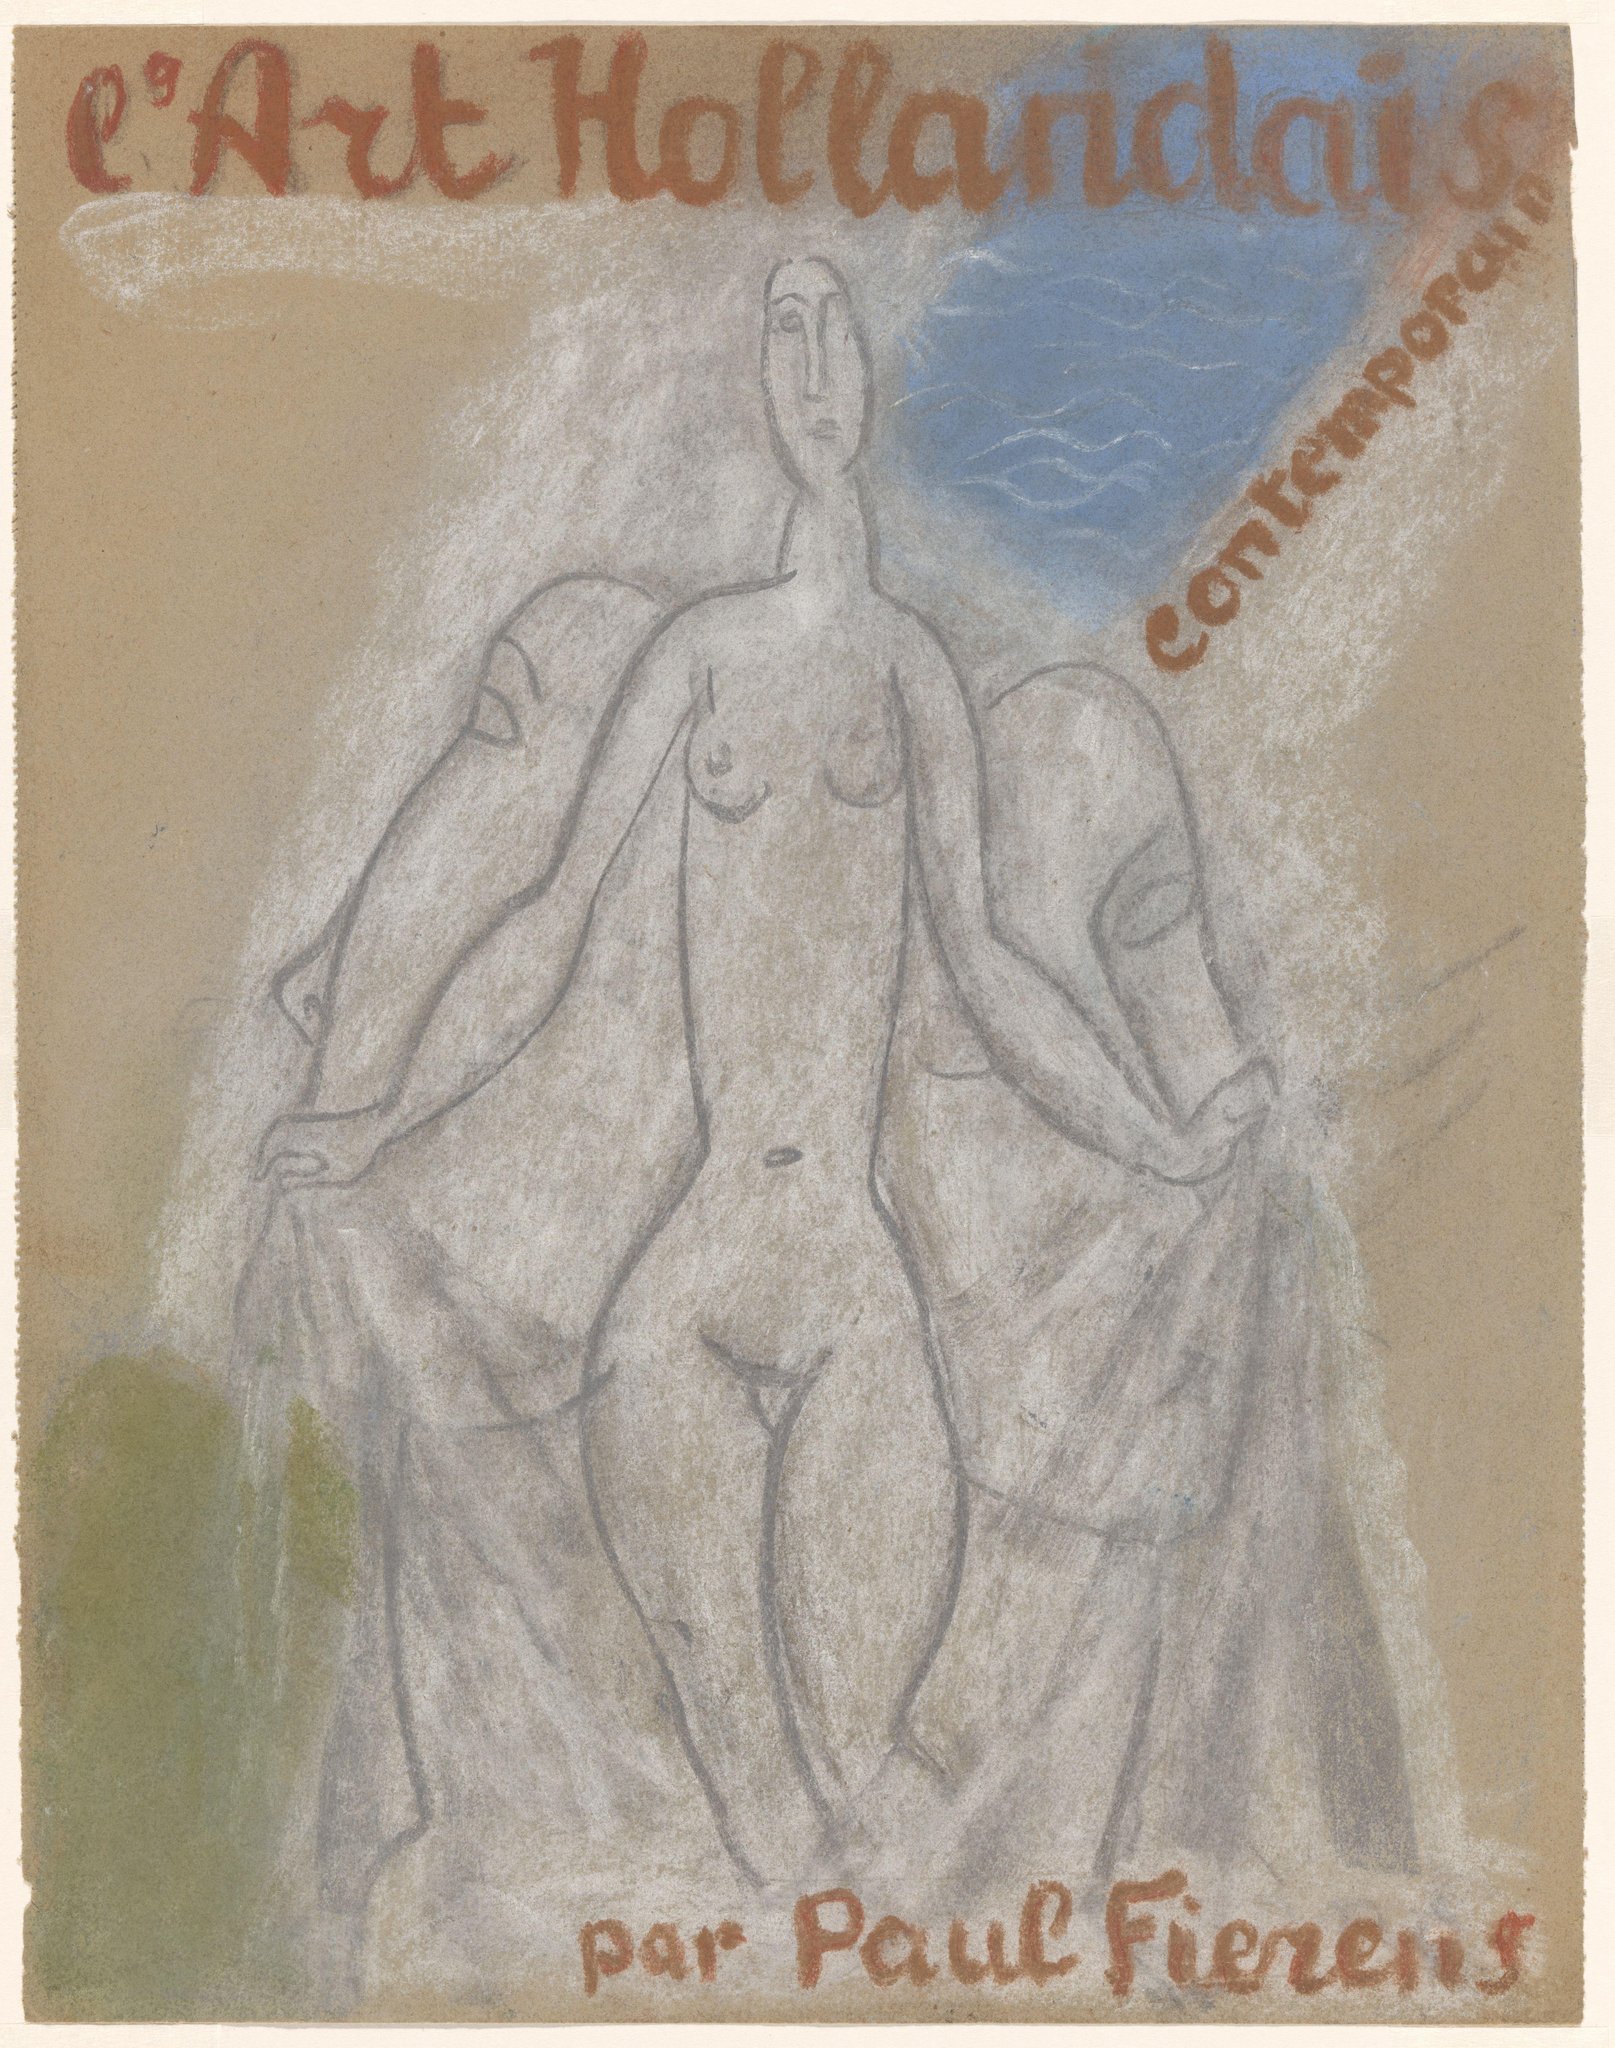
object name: drawing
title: Ontwerp boekomslag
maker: leo gestel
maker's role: draughtsman, print maker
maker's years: 1881-1941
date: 1925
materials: chalk, paper, pencil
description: Ontwerp boekomslag voor Paul Fierens, "l'Art Hollandais contemporain" (Parijs 1933).